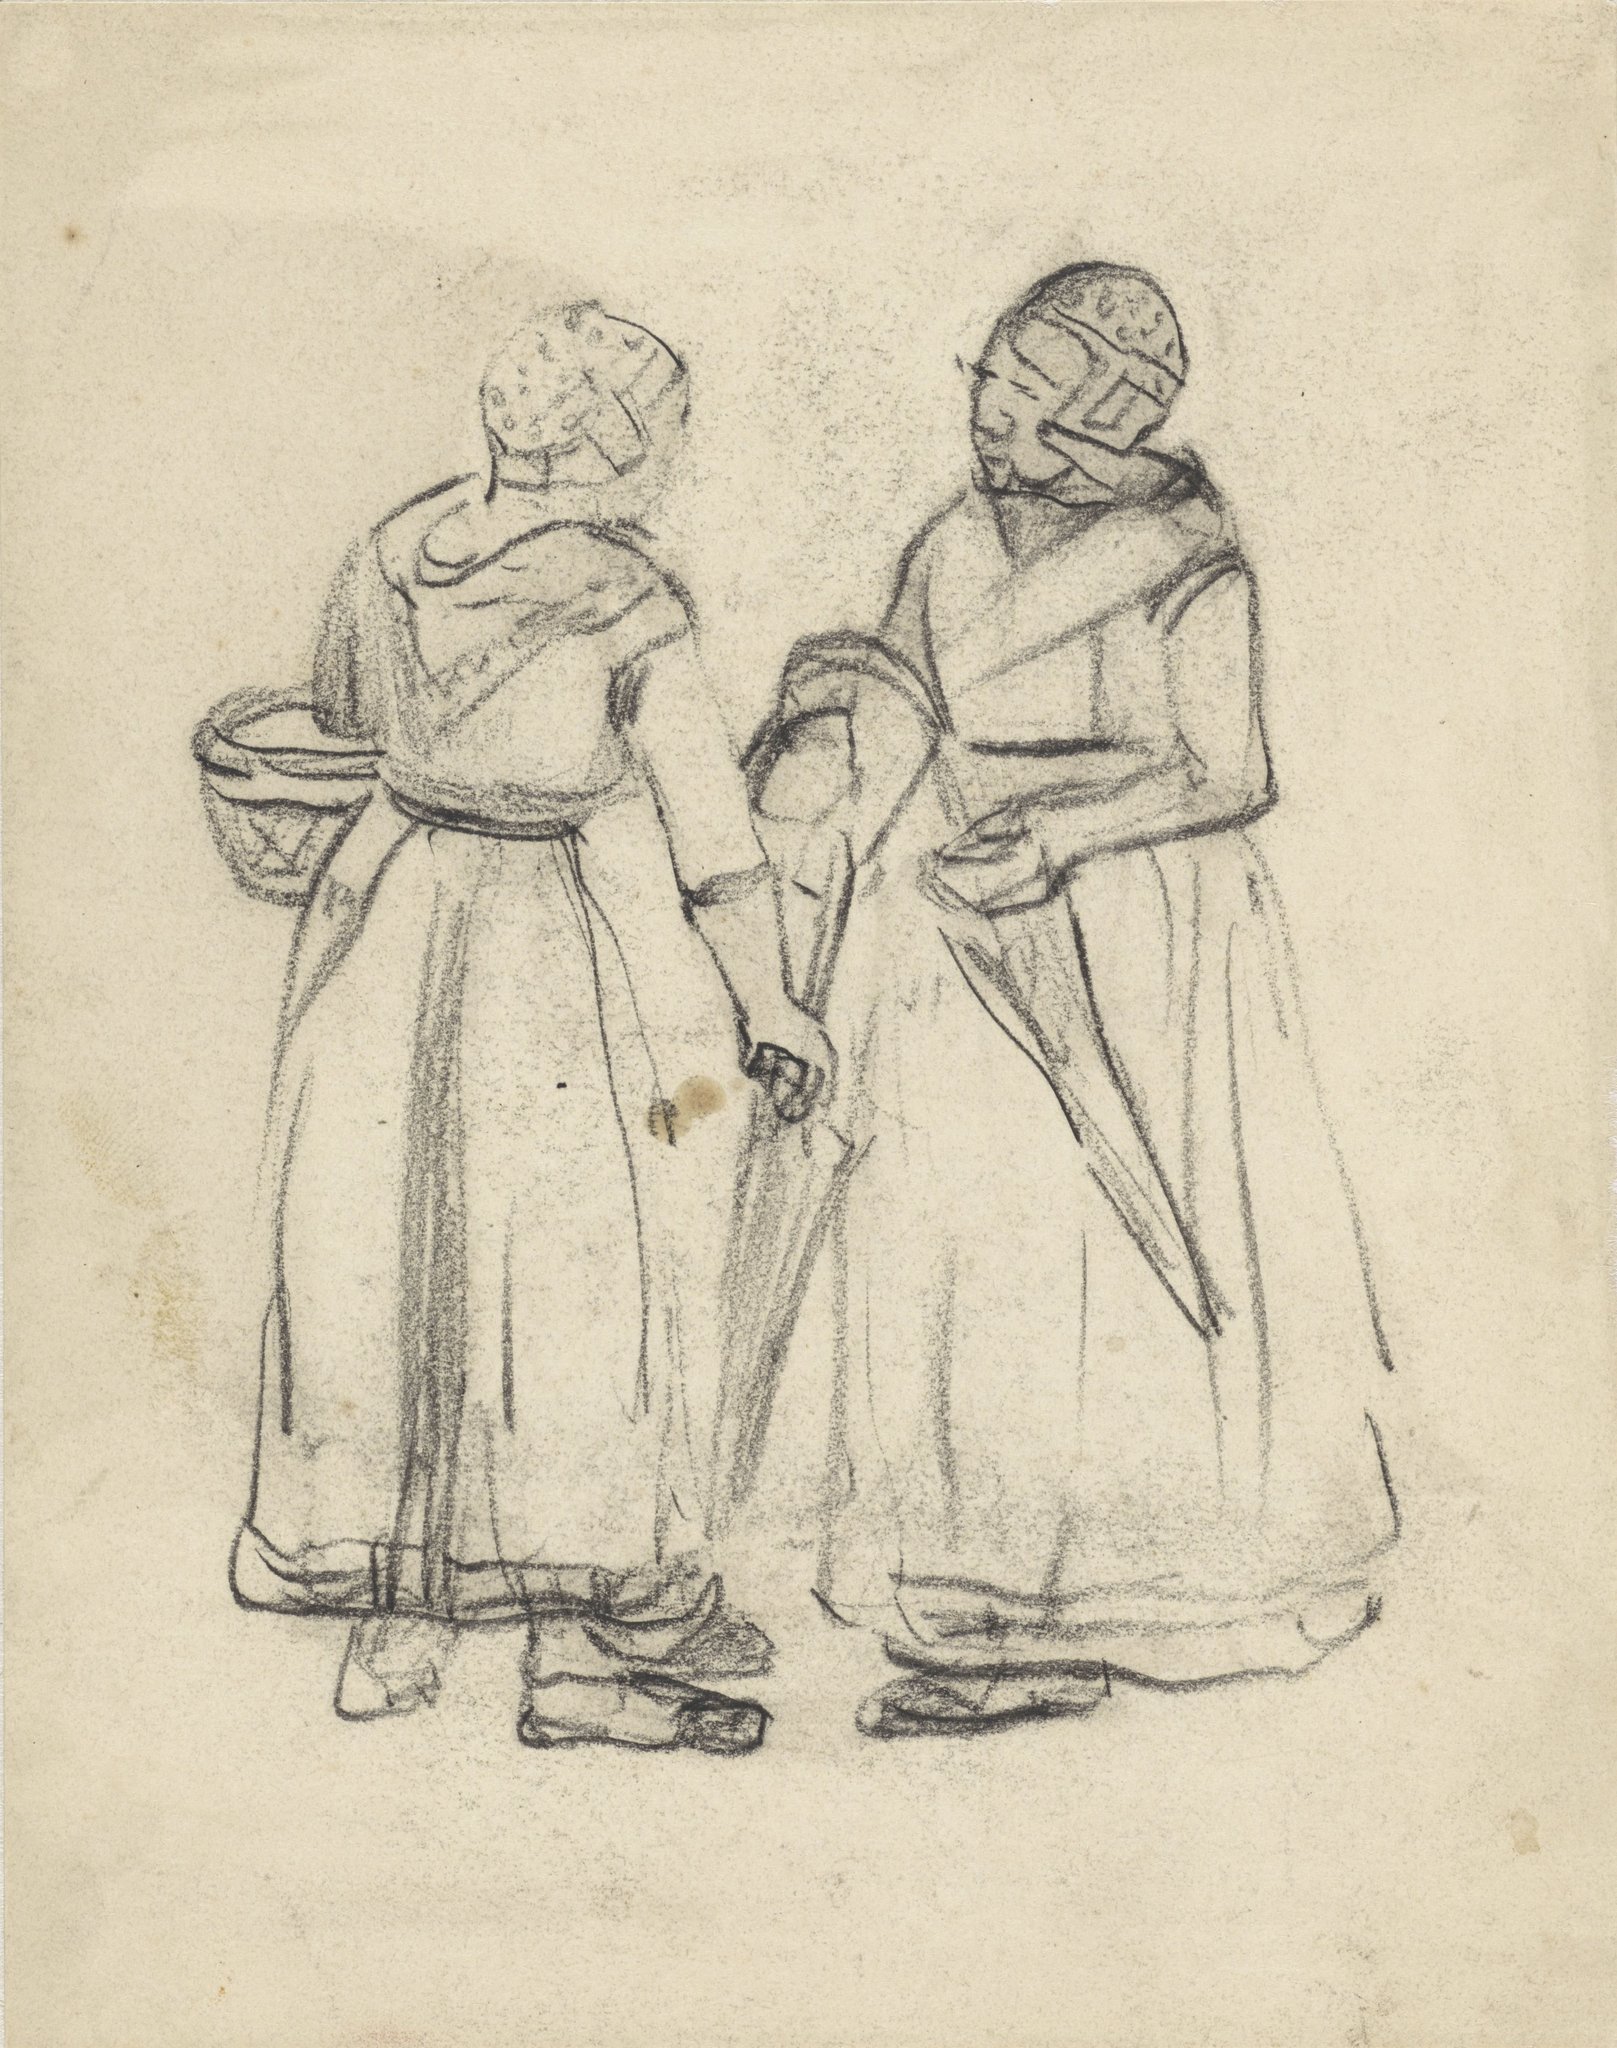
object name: drawing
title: Twee staande vissersvrouwen, in gesprek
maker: johannes abraham mondt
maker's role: draughtsman, print maker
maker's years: 1859-1941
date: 1869-1941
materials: chalk, paper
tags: folk costume, regional costume